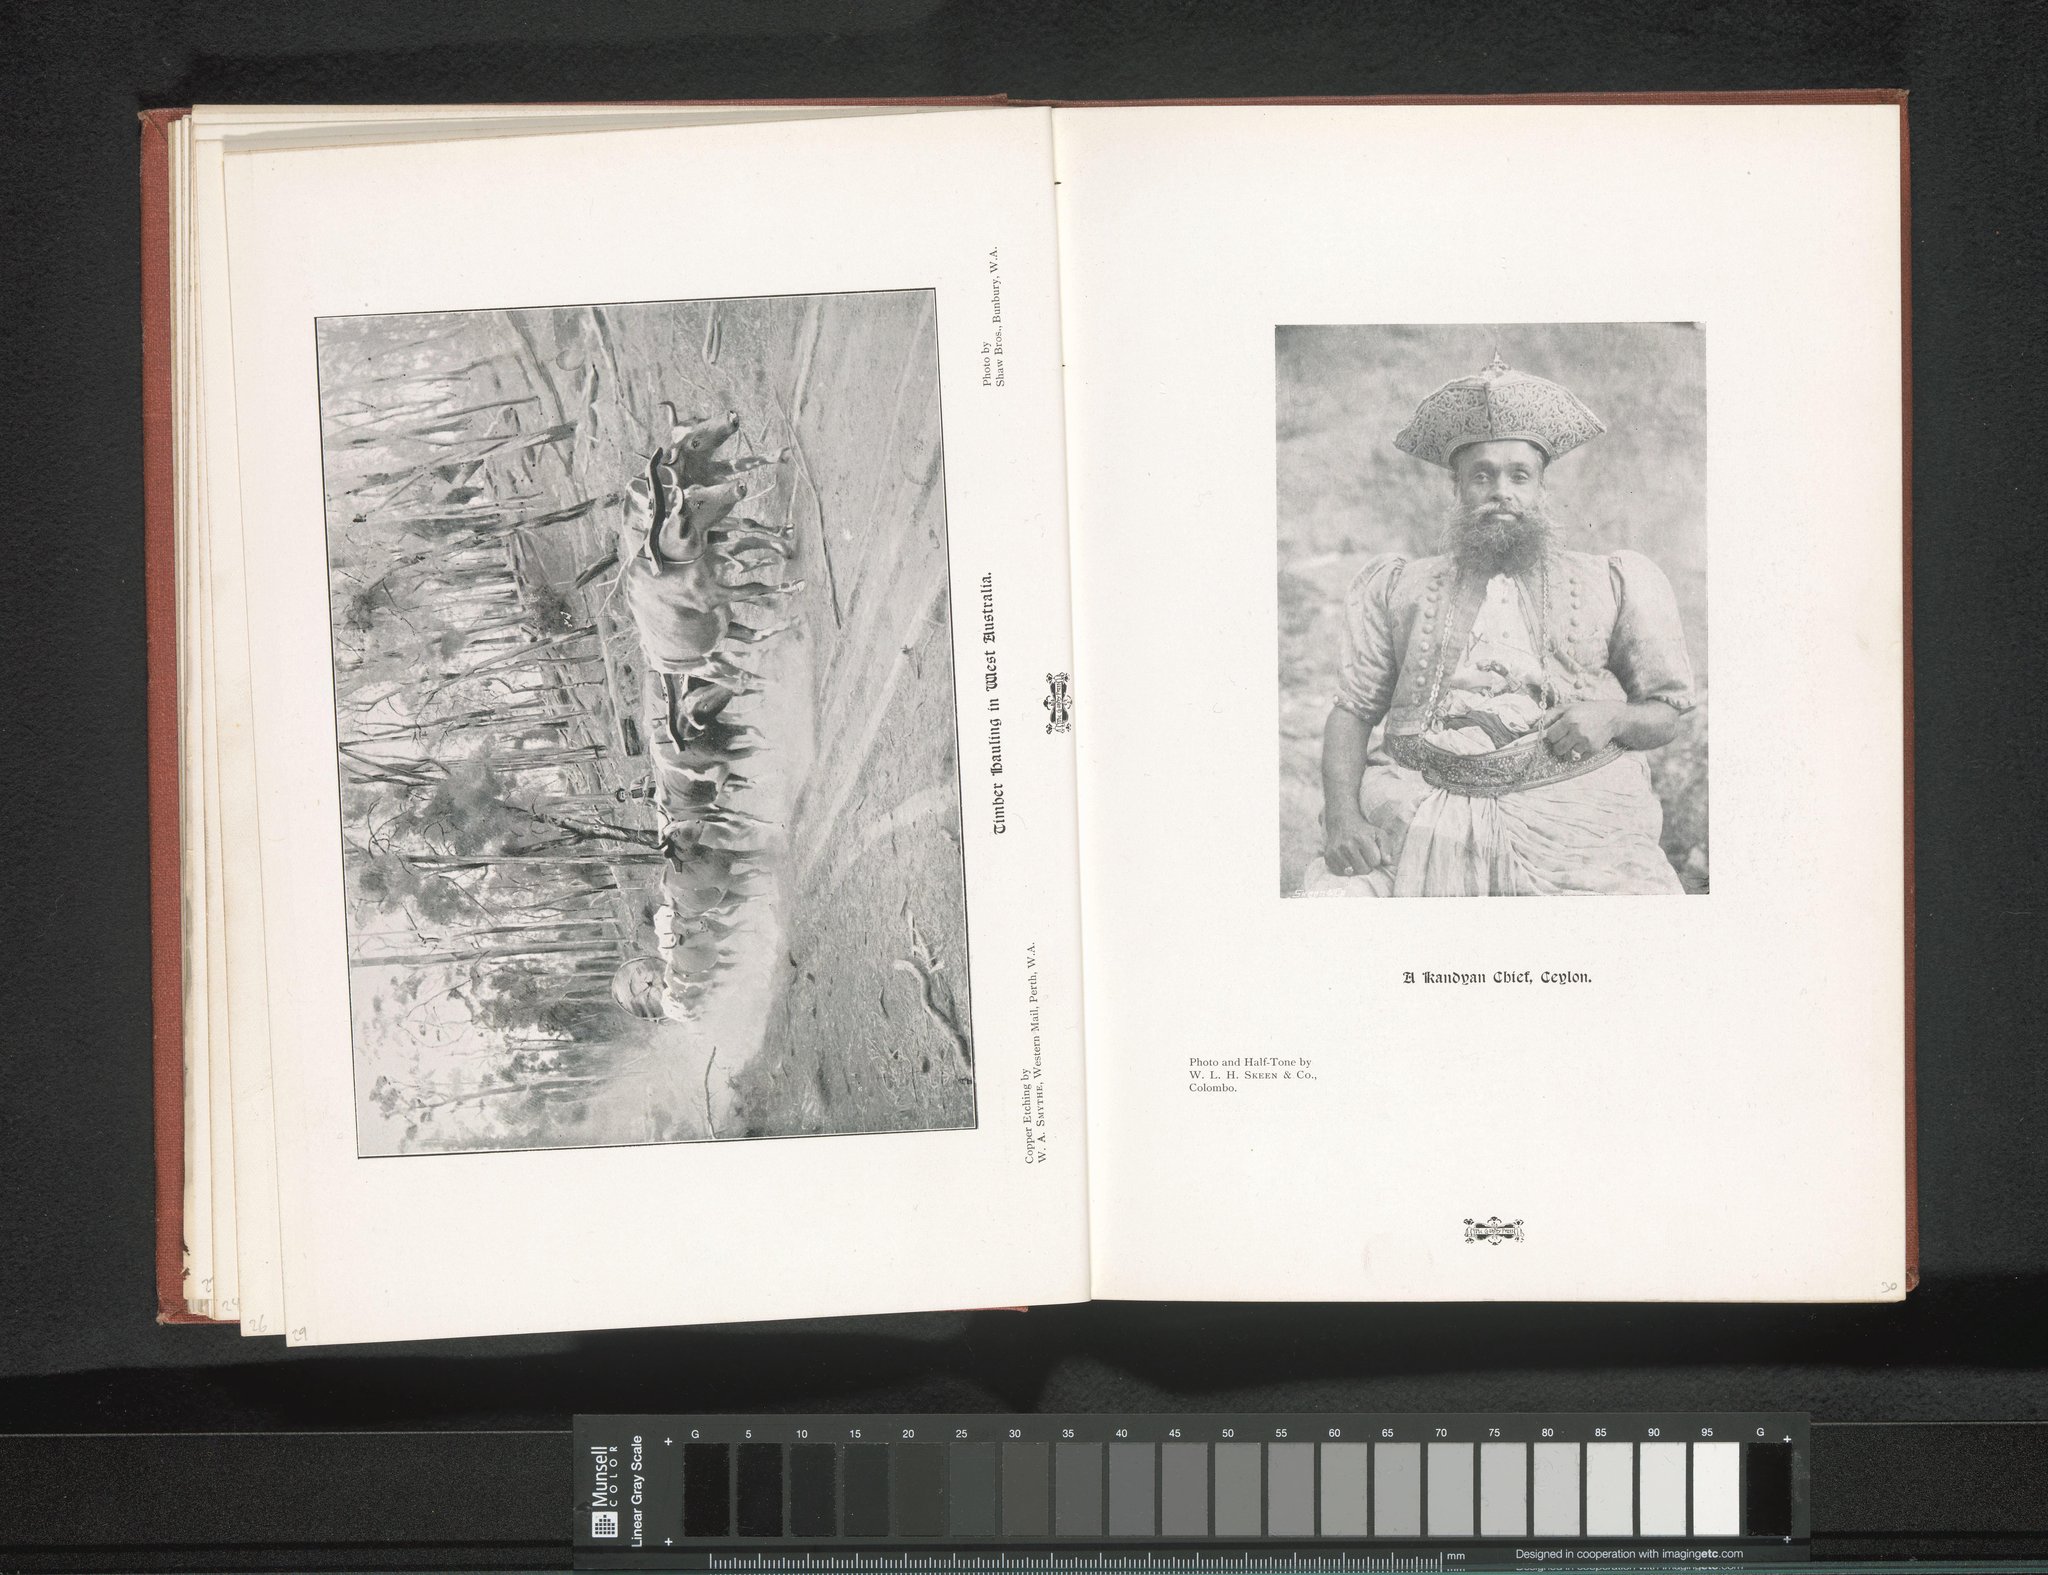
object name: page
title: Timber hauling in West Australia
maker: w.a. smythe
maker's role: printer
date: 1895-1900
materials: paper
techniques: autotype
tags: commander-in-chief, general, marshal, historical persons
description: Prent op tiende ongenummerde pagina na pagina 24.